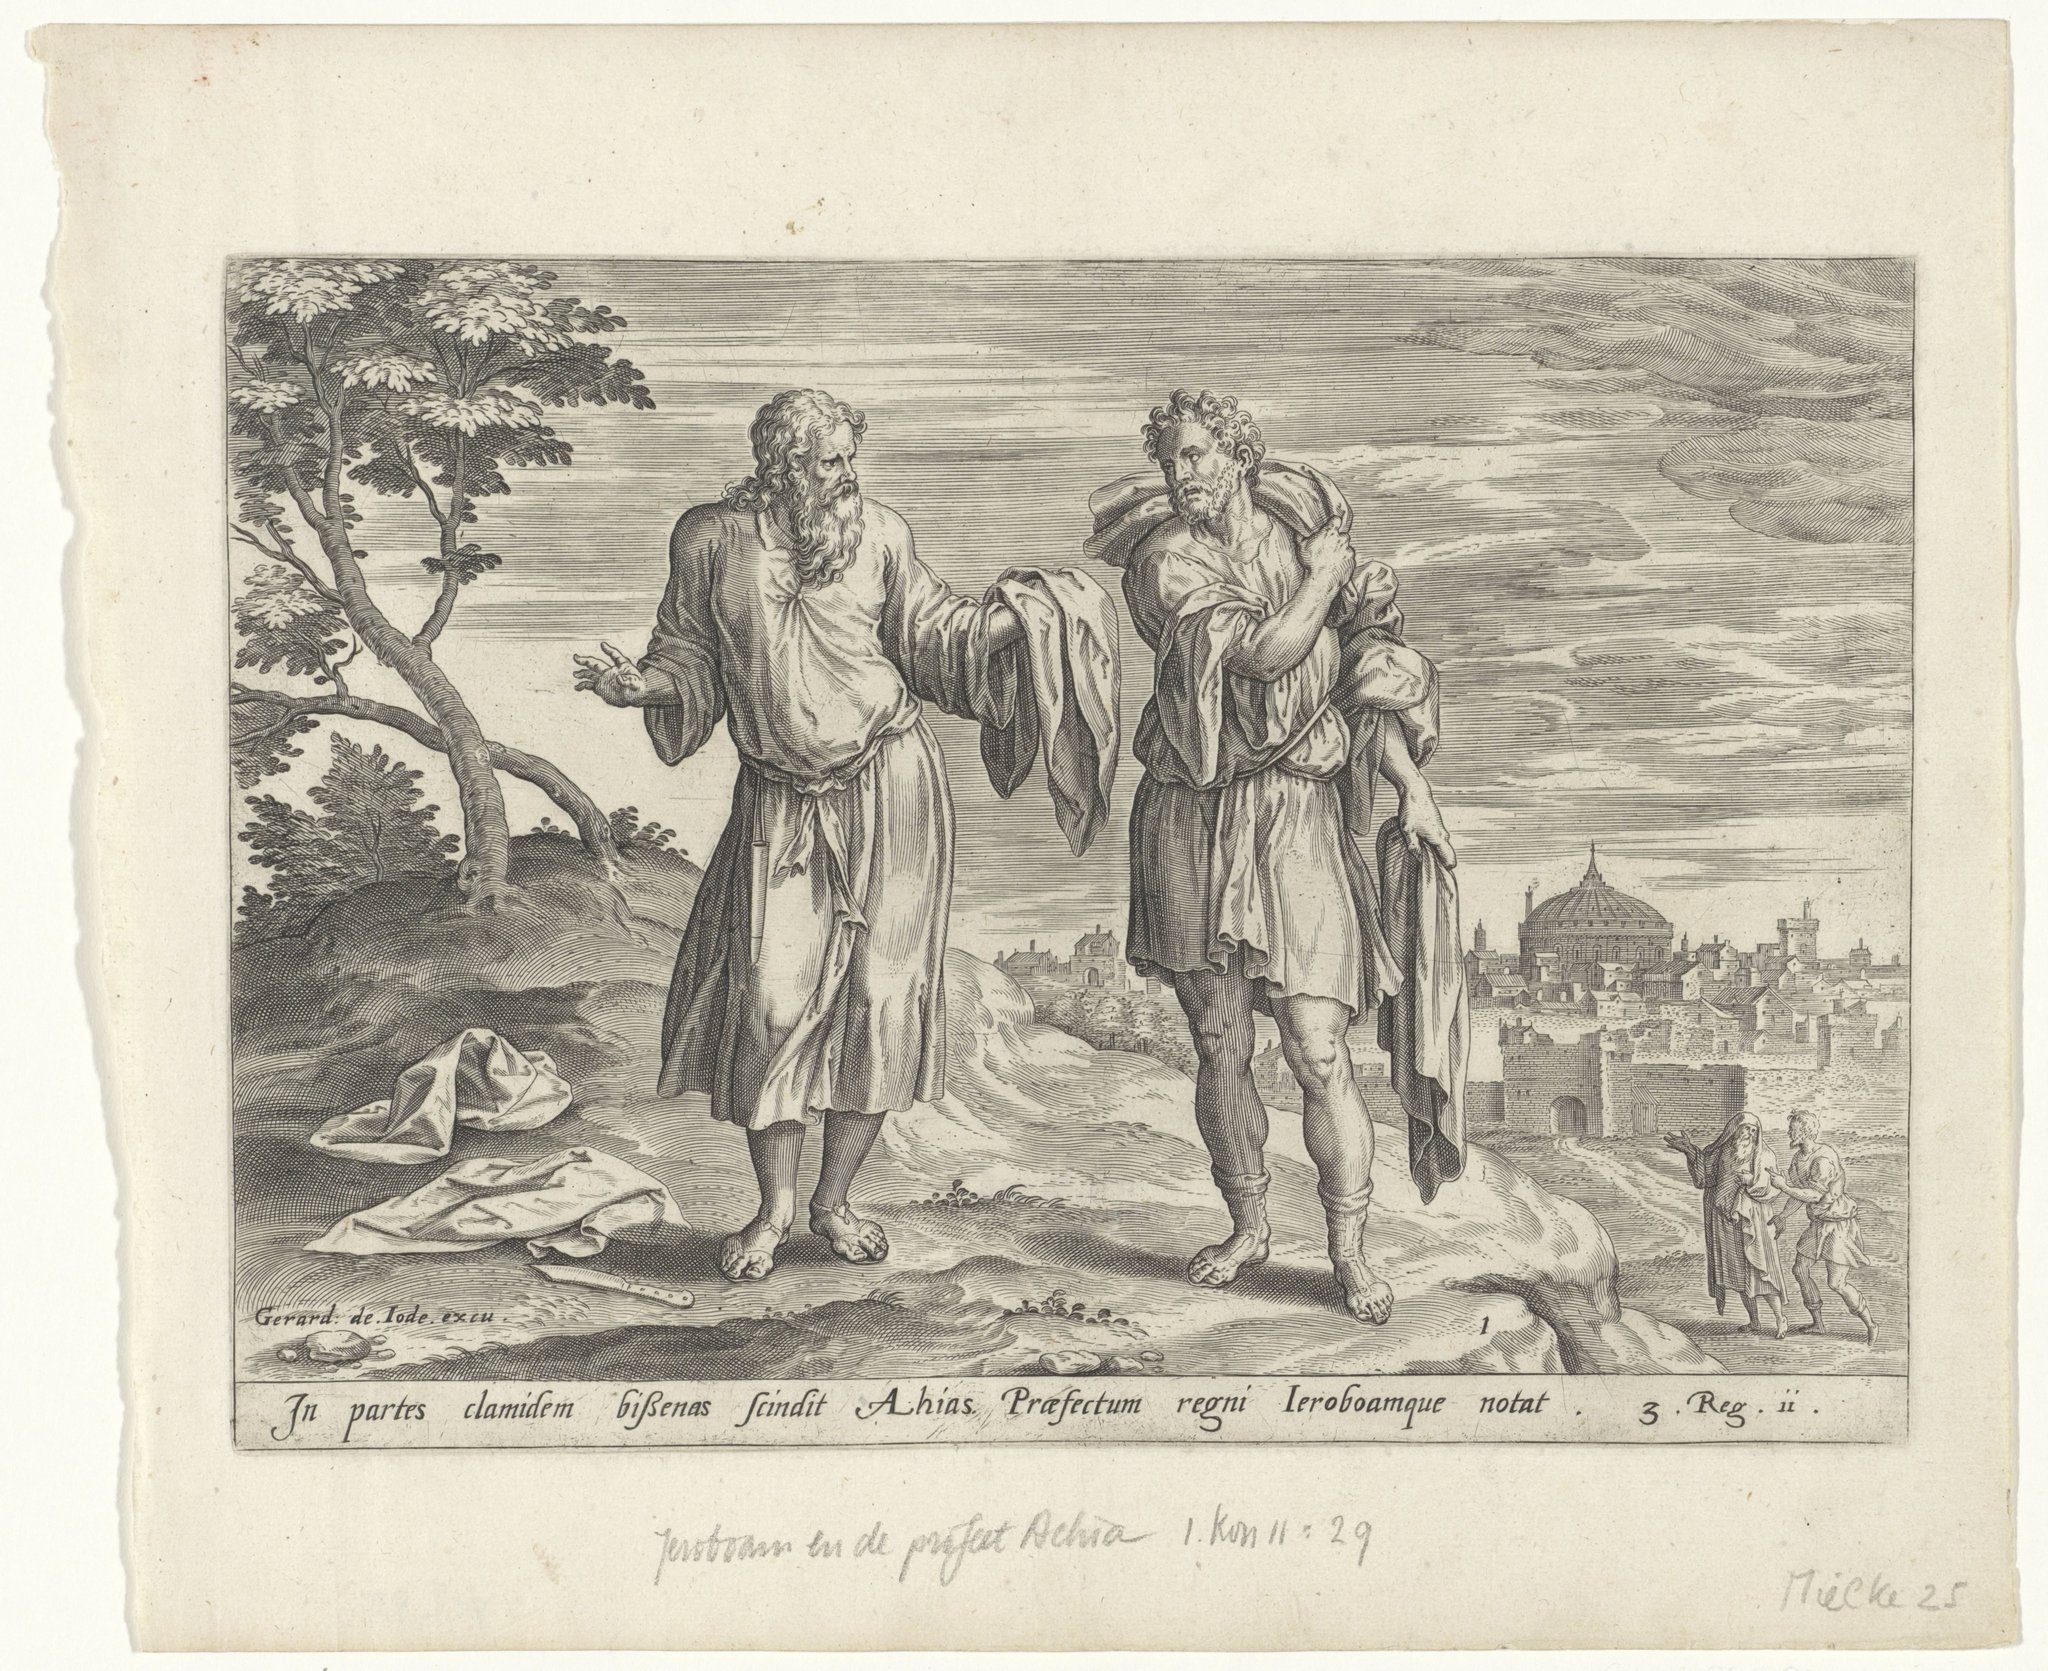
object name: print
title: Thesaurus sacrarum historiarum veteris testamenti (...)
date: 1579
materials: paper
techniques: engraving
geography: antwerp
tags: meeting of jeroboam and the prophet ahijah; ahijah rends his garment in twelve pieces, ten of which he gives to jeroboam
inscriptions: inscription: ‘Jeroboam en de profeet Achia 1. kon 11:29’, collector's mark: Lugt 2228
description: Prent gebruikt in: Thesaurus sacrarum historiaru veteris testamenti, elegatissimis imaginibus expressu excelletissimoru in hac arte viroru opera : nuc primu in luce editus. Antwerpen: Gerard de Jode, 1579. Of prent gebruikt in: Thesaurus sacrarum historiaru[m] veteris (et novi) testame[n]ti, elega[n]tissimis imaginibus expressu[m] excelle[n]tissimoru[m] in hac arte viroru[m] opera : nu[n]c primu[m] in luce[m] editus. Antwerpen: Gerard de Jode, 1585.